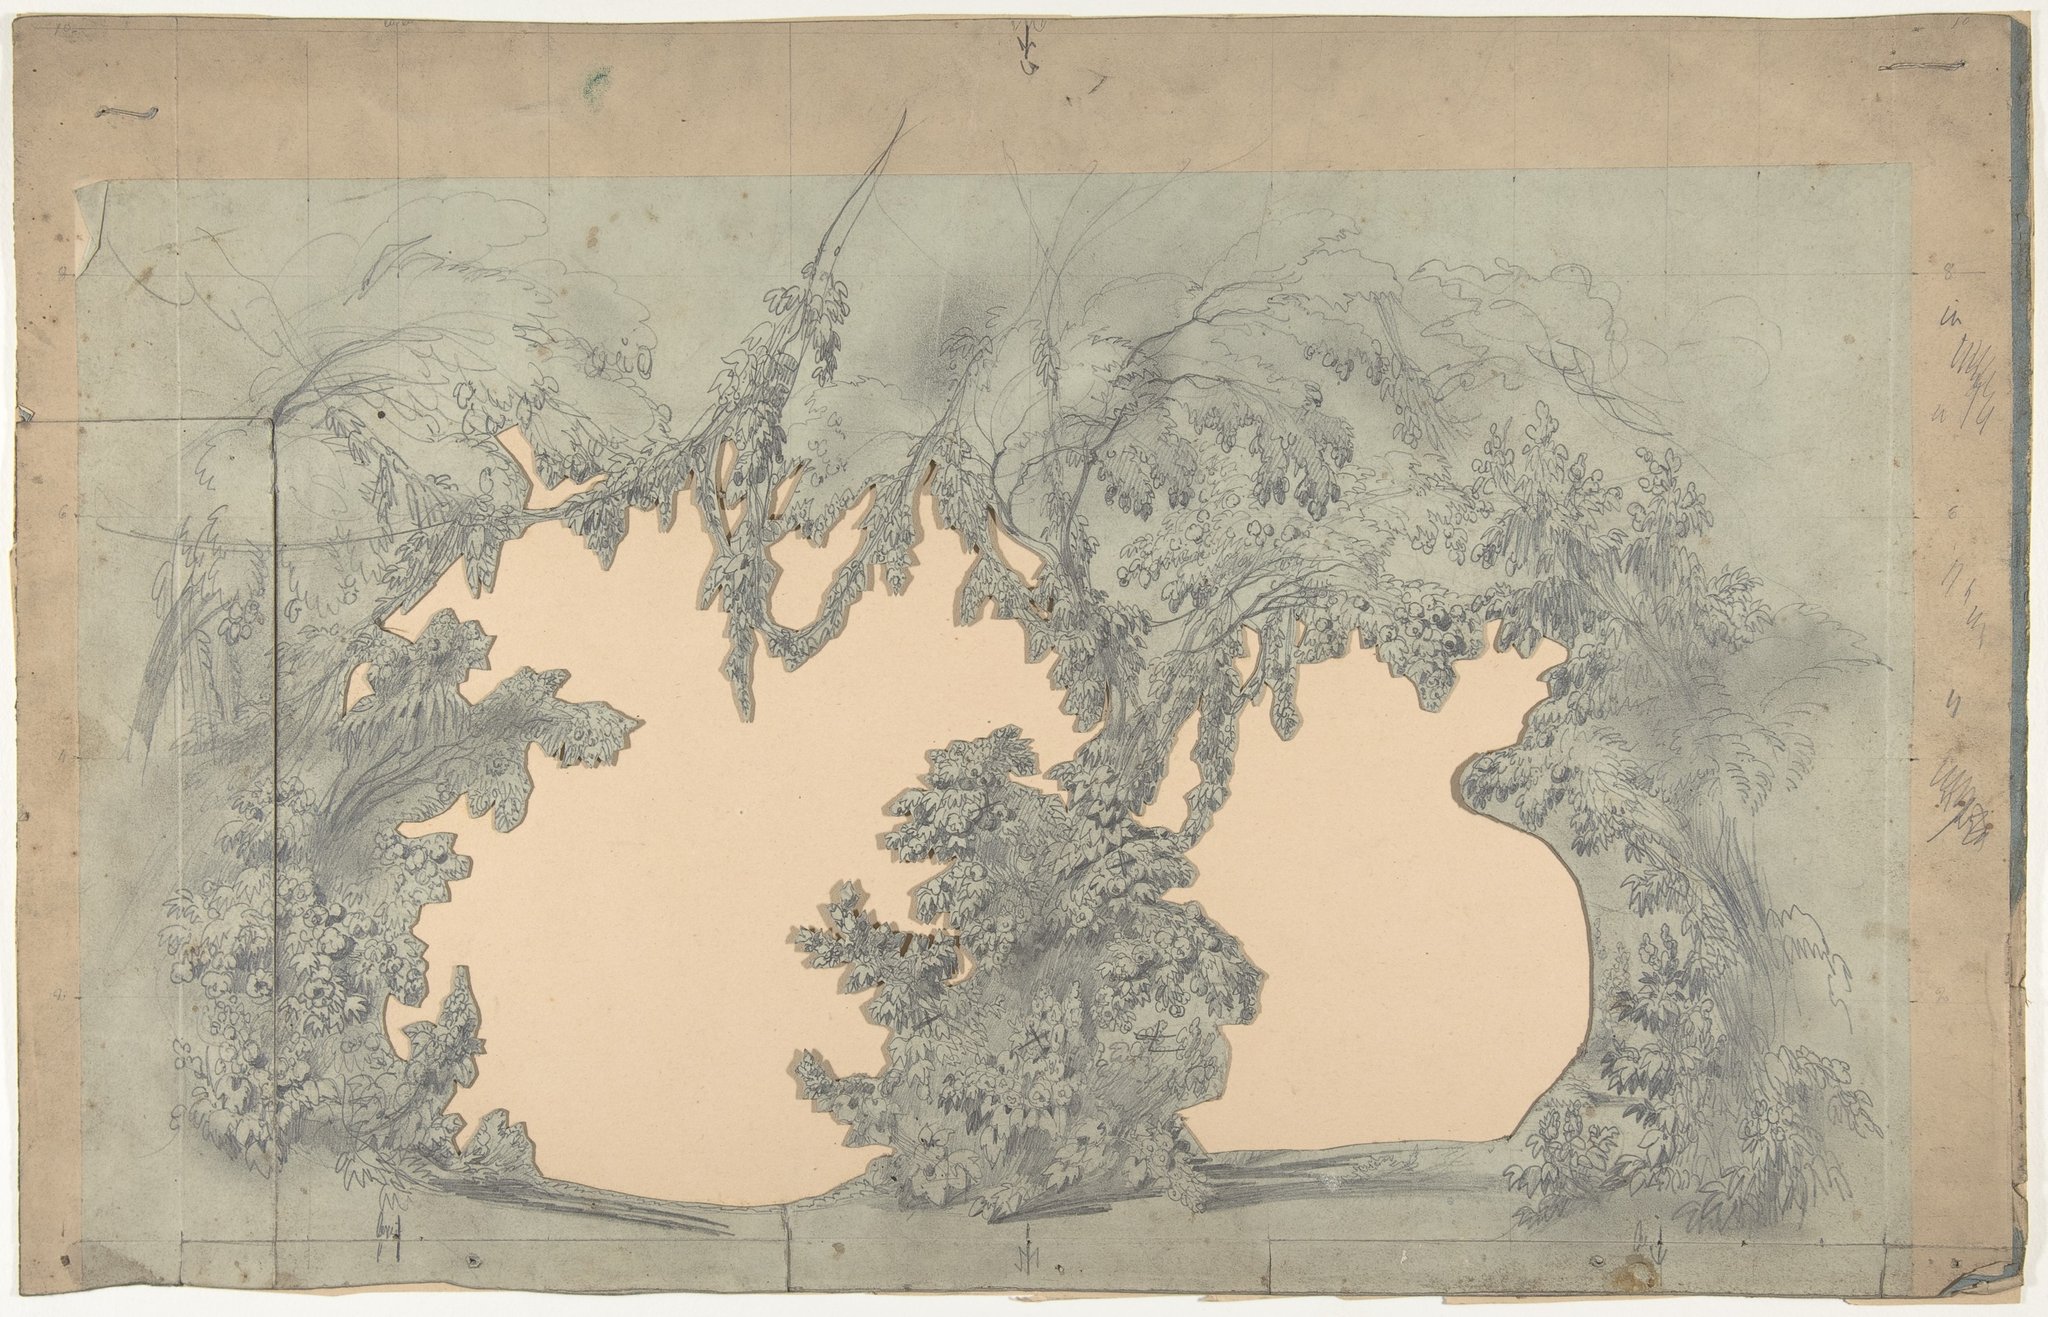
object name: drawing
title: Design for a Stage Set at the Opéra, Paris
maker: eugène cicéri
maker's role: artist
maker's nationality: french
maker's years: 1813-1890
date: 1828-1890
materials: graphite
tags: stage design